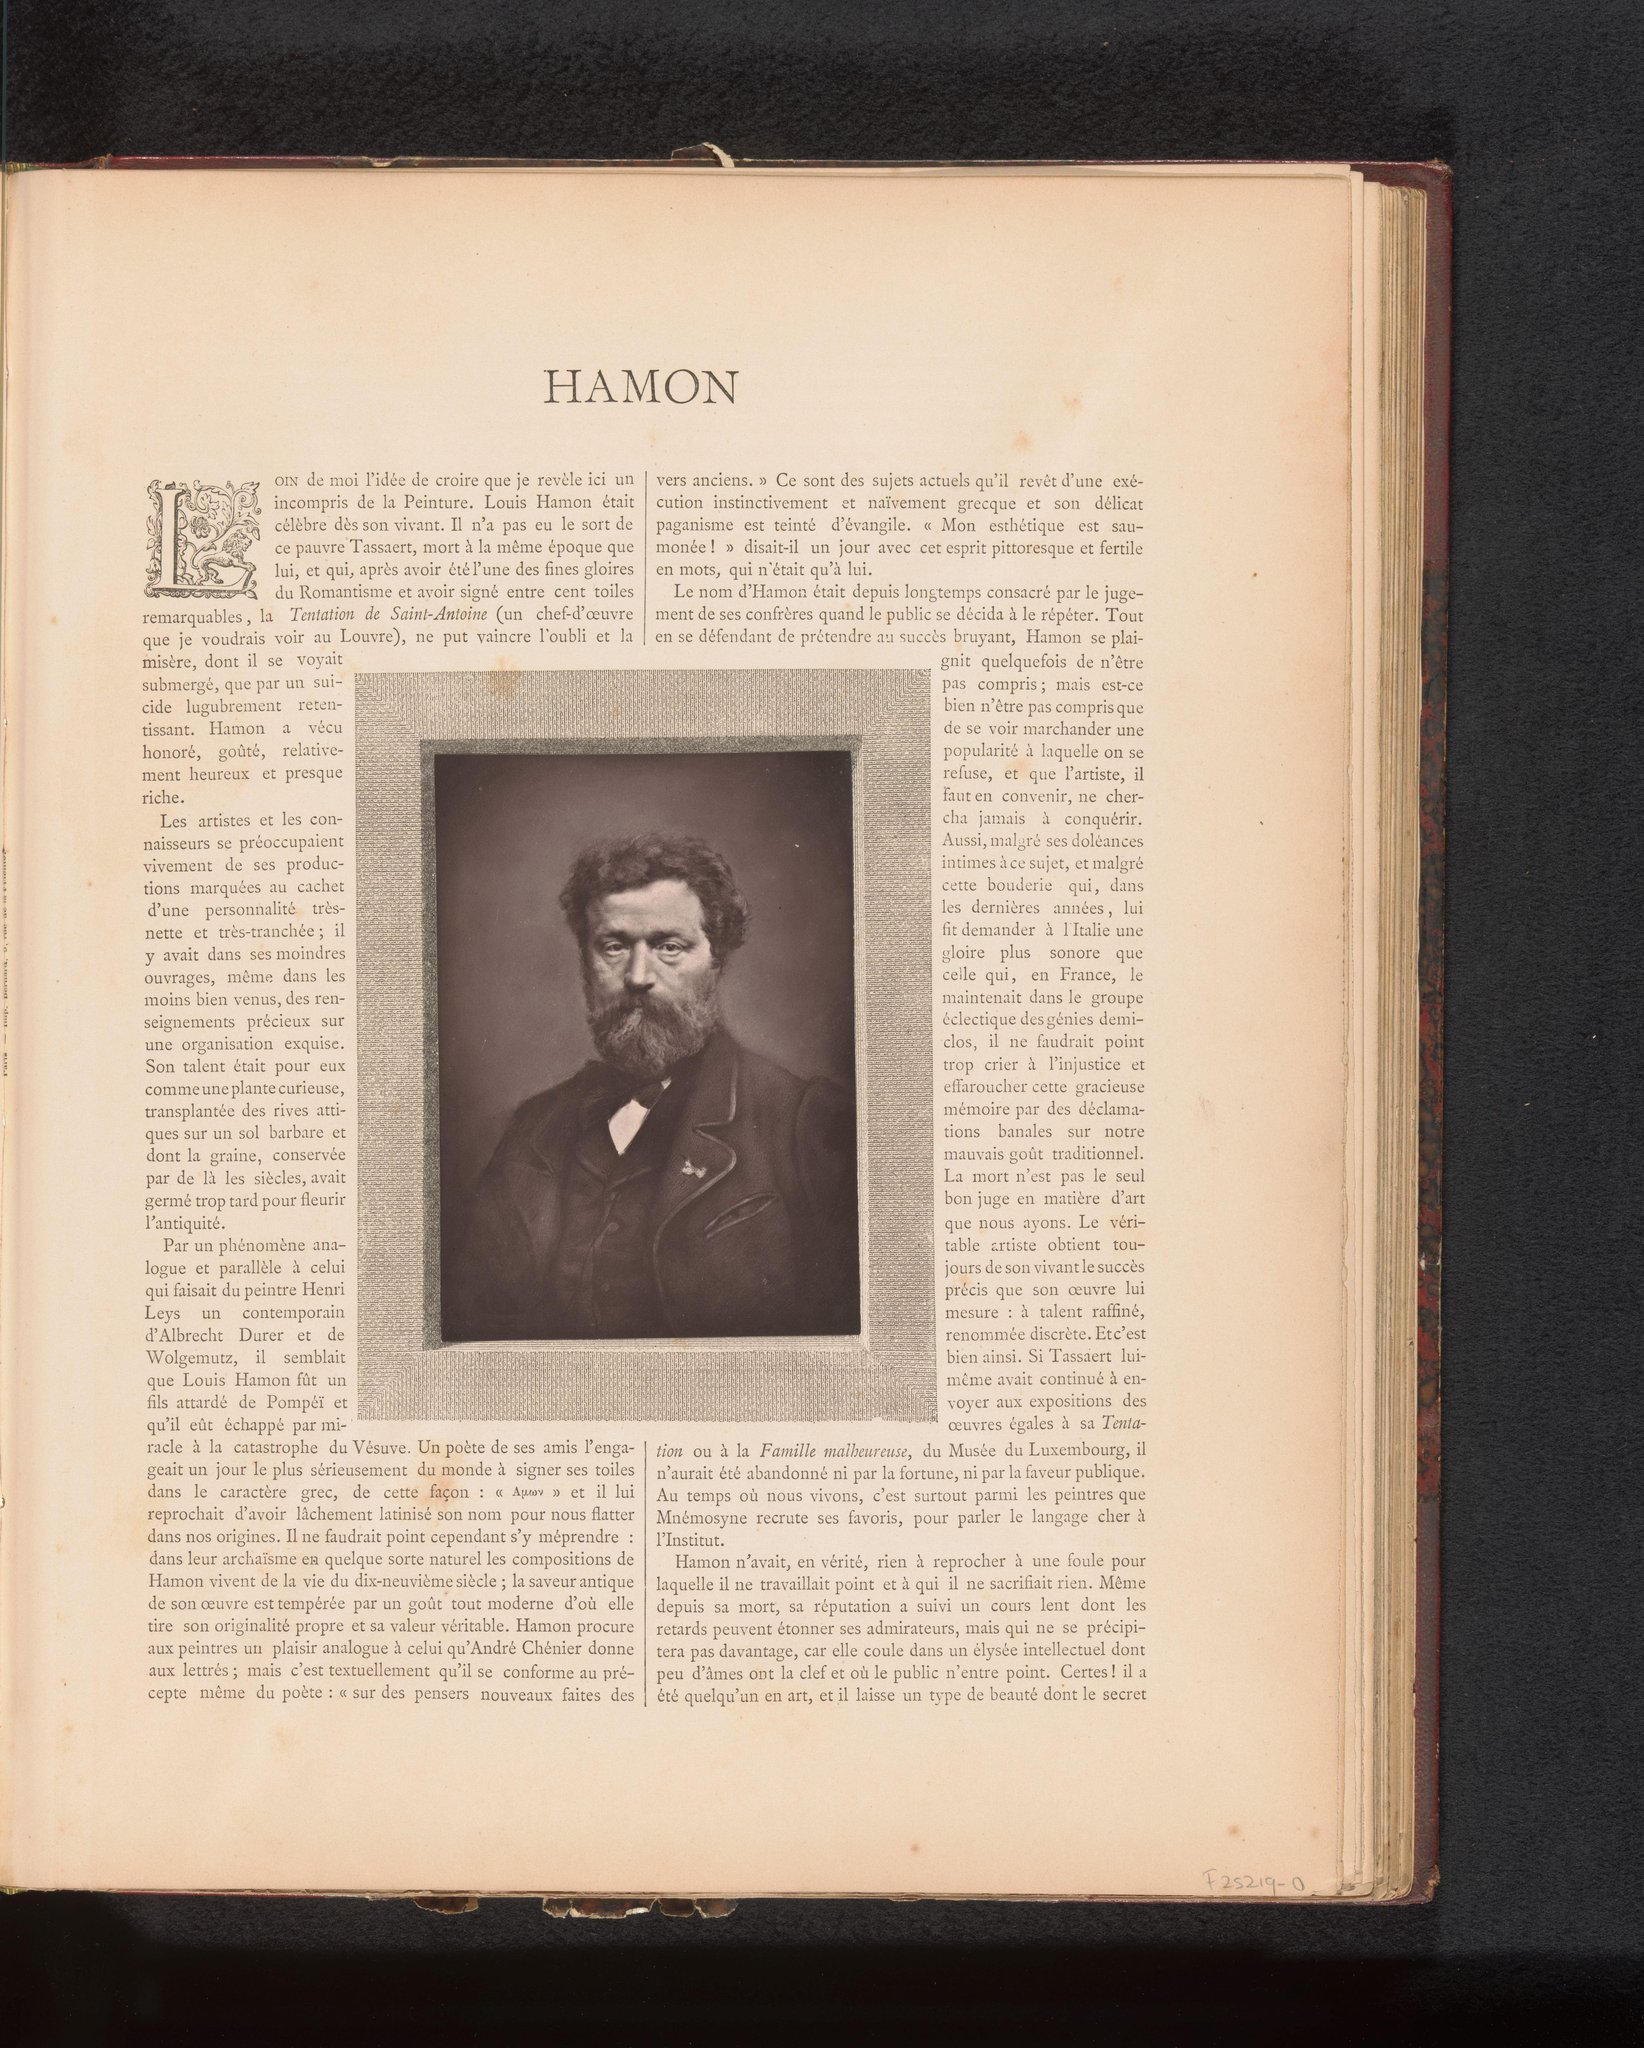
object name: page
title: Hamon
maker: Anonymous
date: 1872-1877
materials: paper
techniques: woodburytype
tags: painter, jean-louis hamon, adult man, historical persons